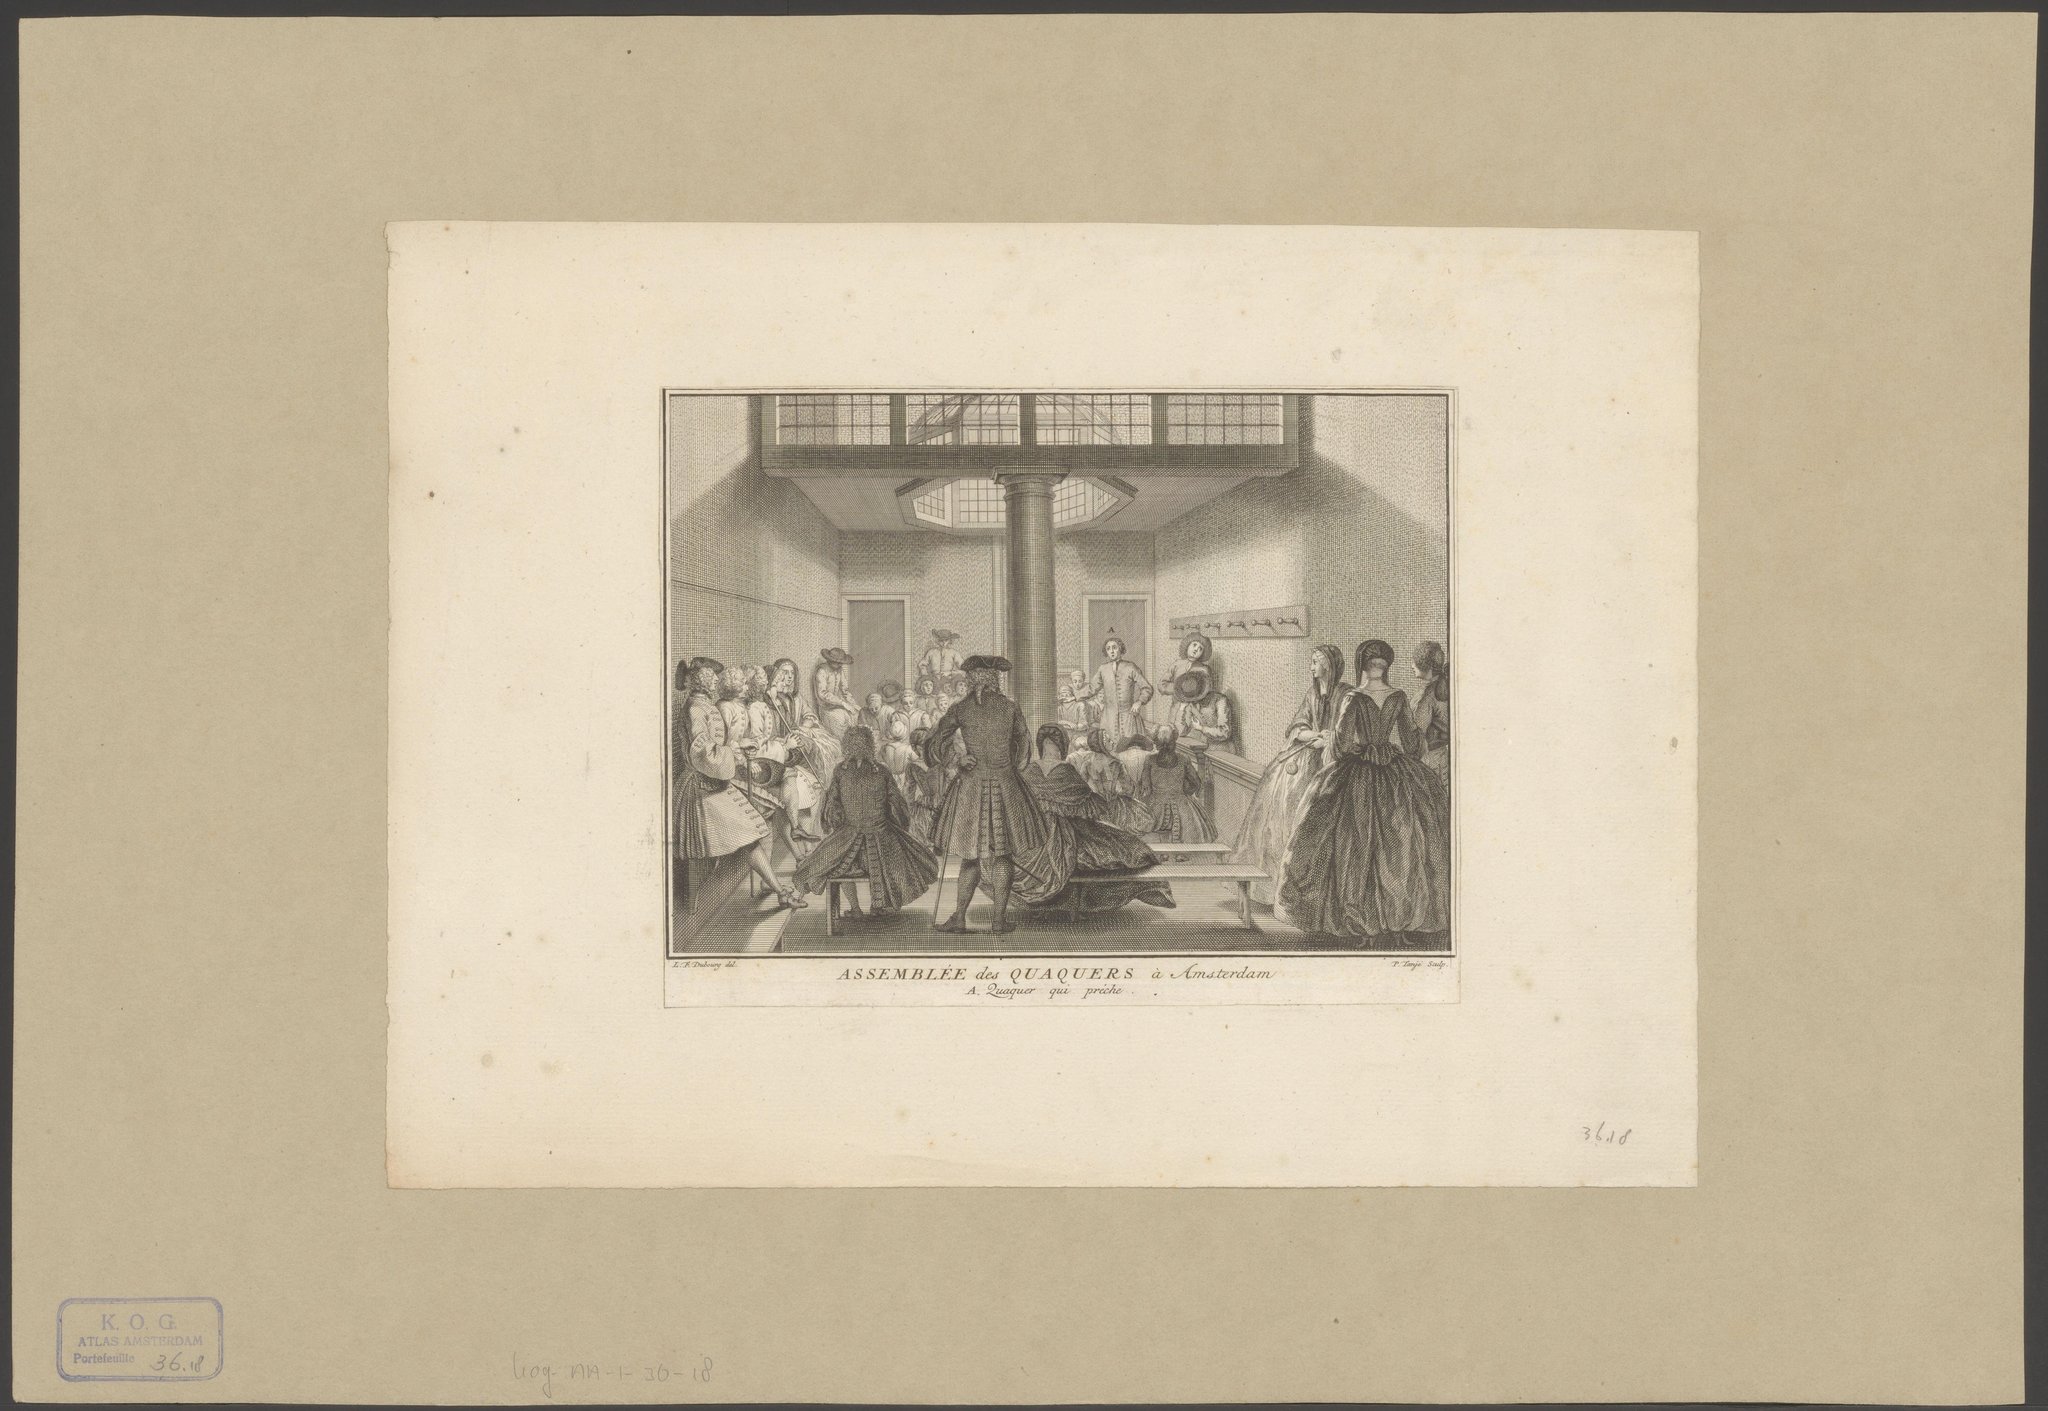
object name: print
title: Assemblée des Quaquers à Amsterdam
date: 1736-1738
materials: paper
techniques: engraving, etching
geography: amsterdam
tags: interior of church, protestant churches and denominations (with name)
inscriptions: collector's mark: Lugt 1641b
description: Bijeenkomst van de Quakers in hun vergaderplaats op de Keizersgracht te Amsterdam (huidige nummer 140). Figuur A preekt terwijl de overige aanwezigen naar hem luisteren. Onderwerpsrubriek binnen de Atlas Amsterdam: Kerkwezen: Vrienden-Gemeente (Kwakers).